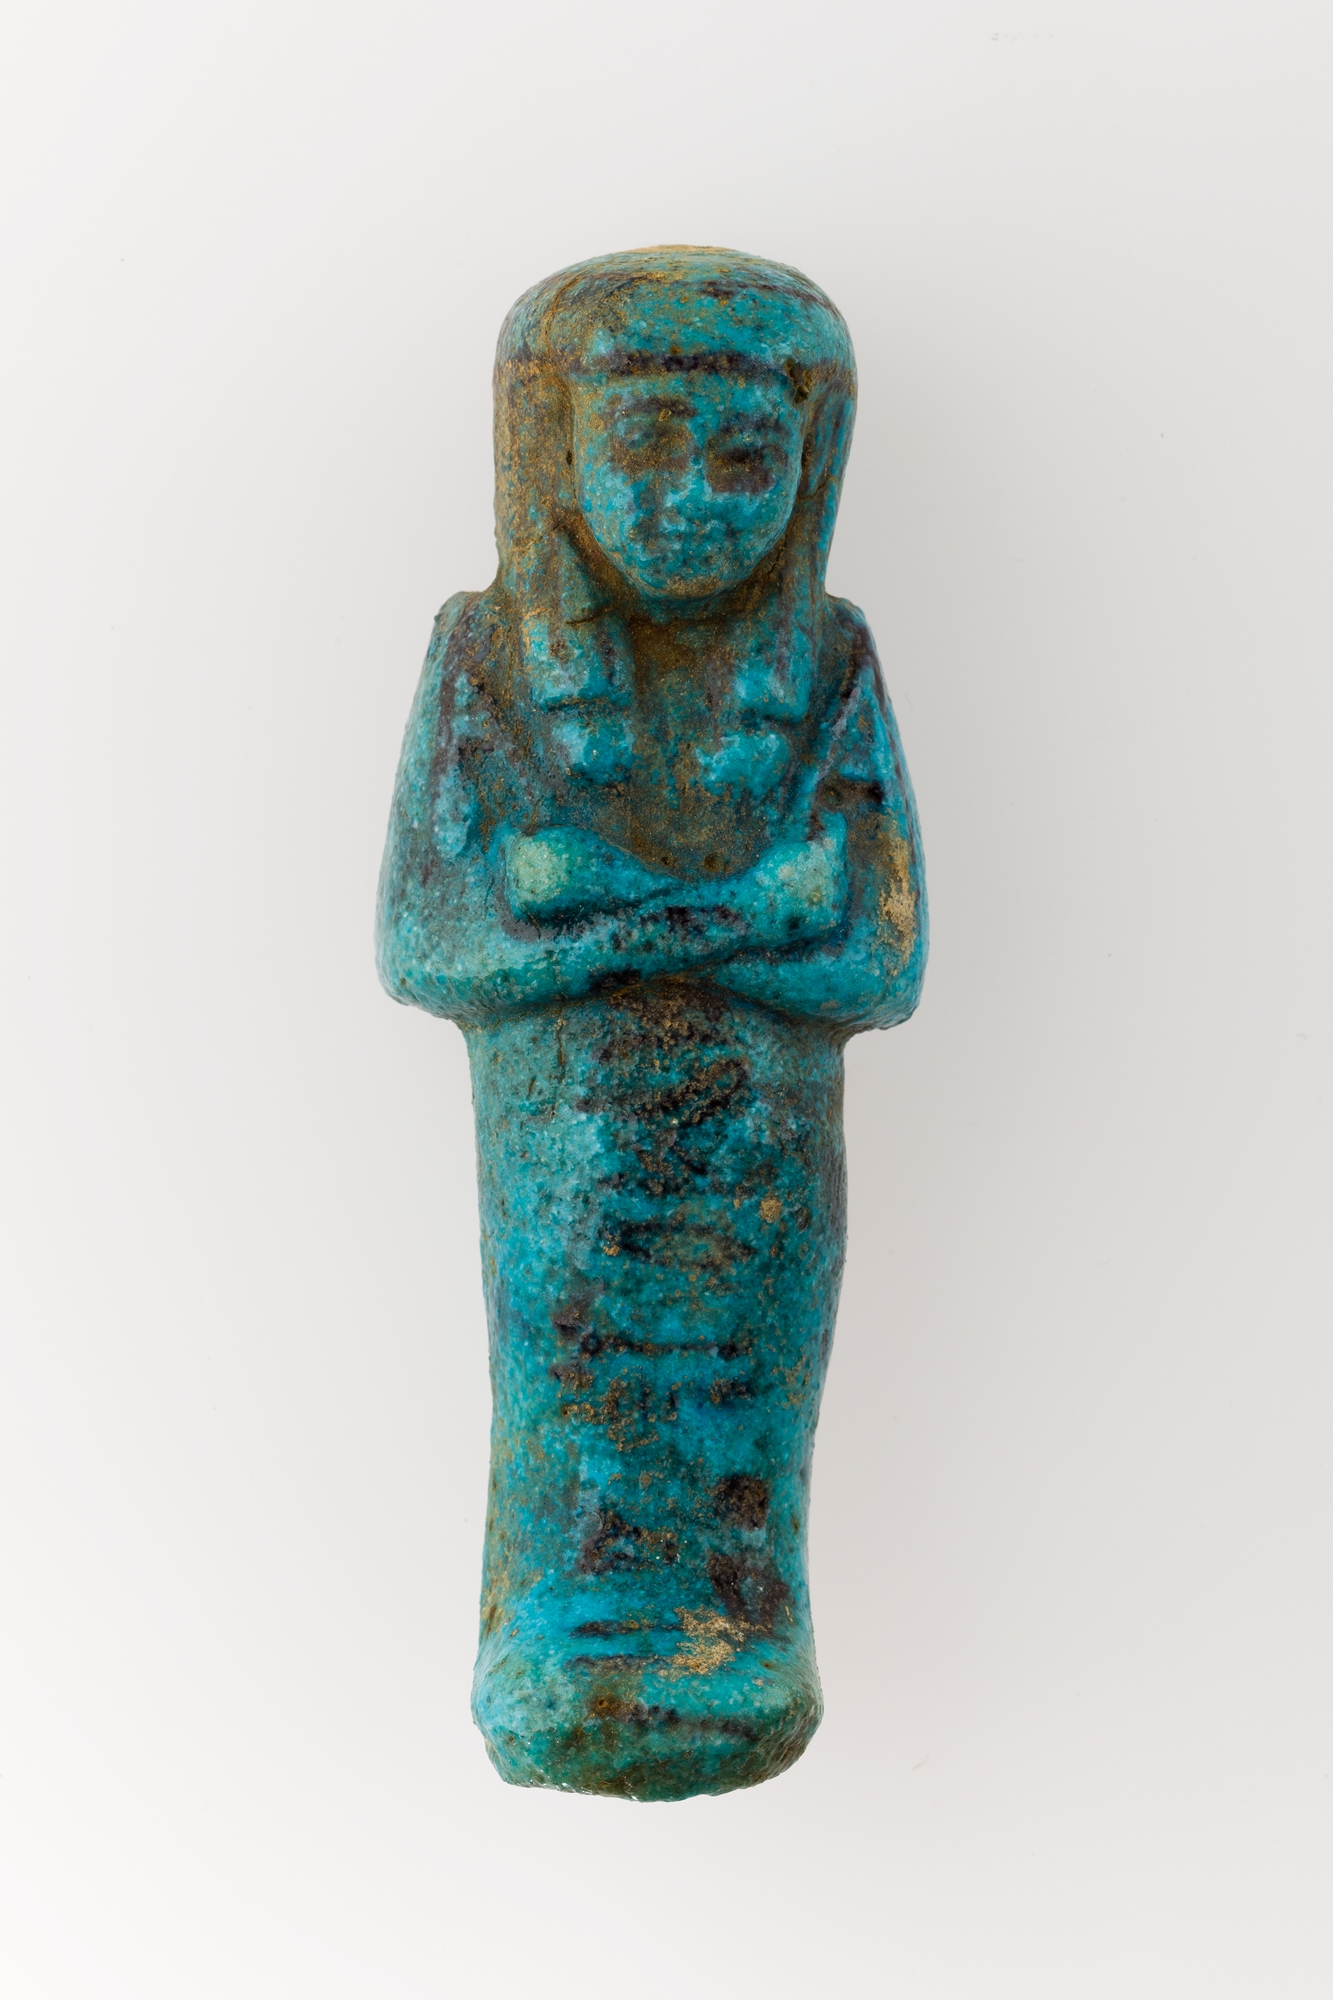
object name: shabti, henettawy c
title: Worker Shabti of Henettawy (C), Daughter of Isetemkheb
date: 990-970 BCE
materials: faience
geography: egypt